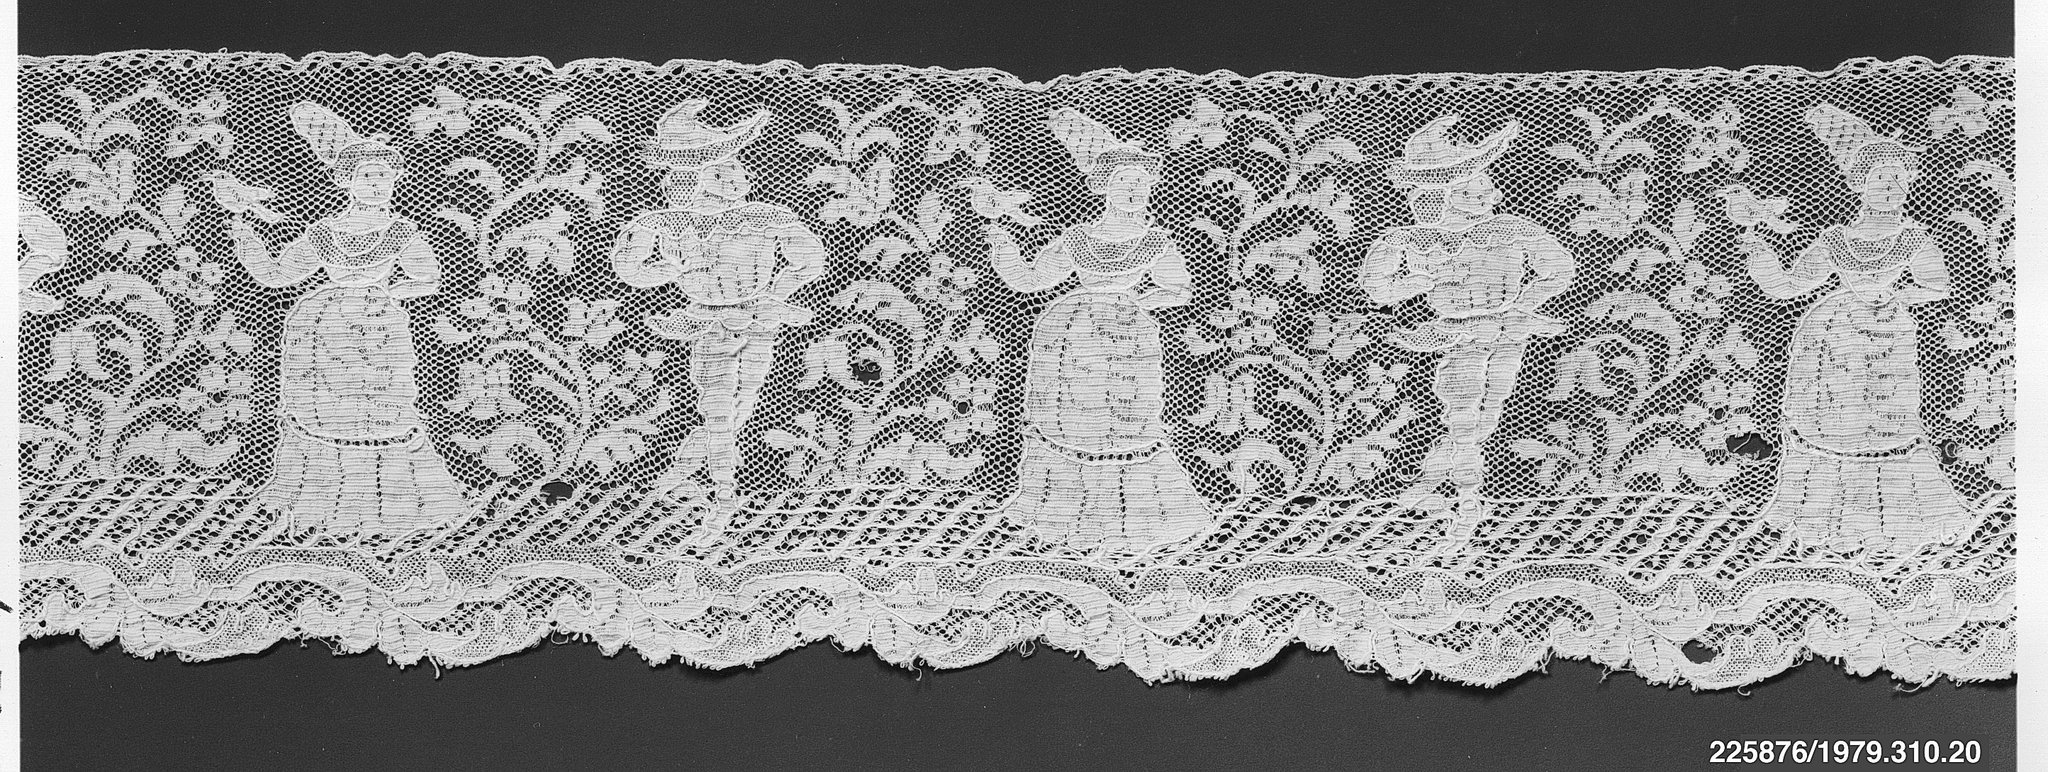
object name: edging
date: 1867-1900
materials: lace, linen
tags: men,women,flowers